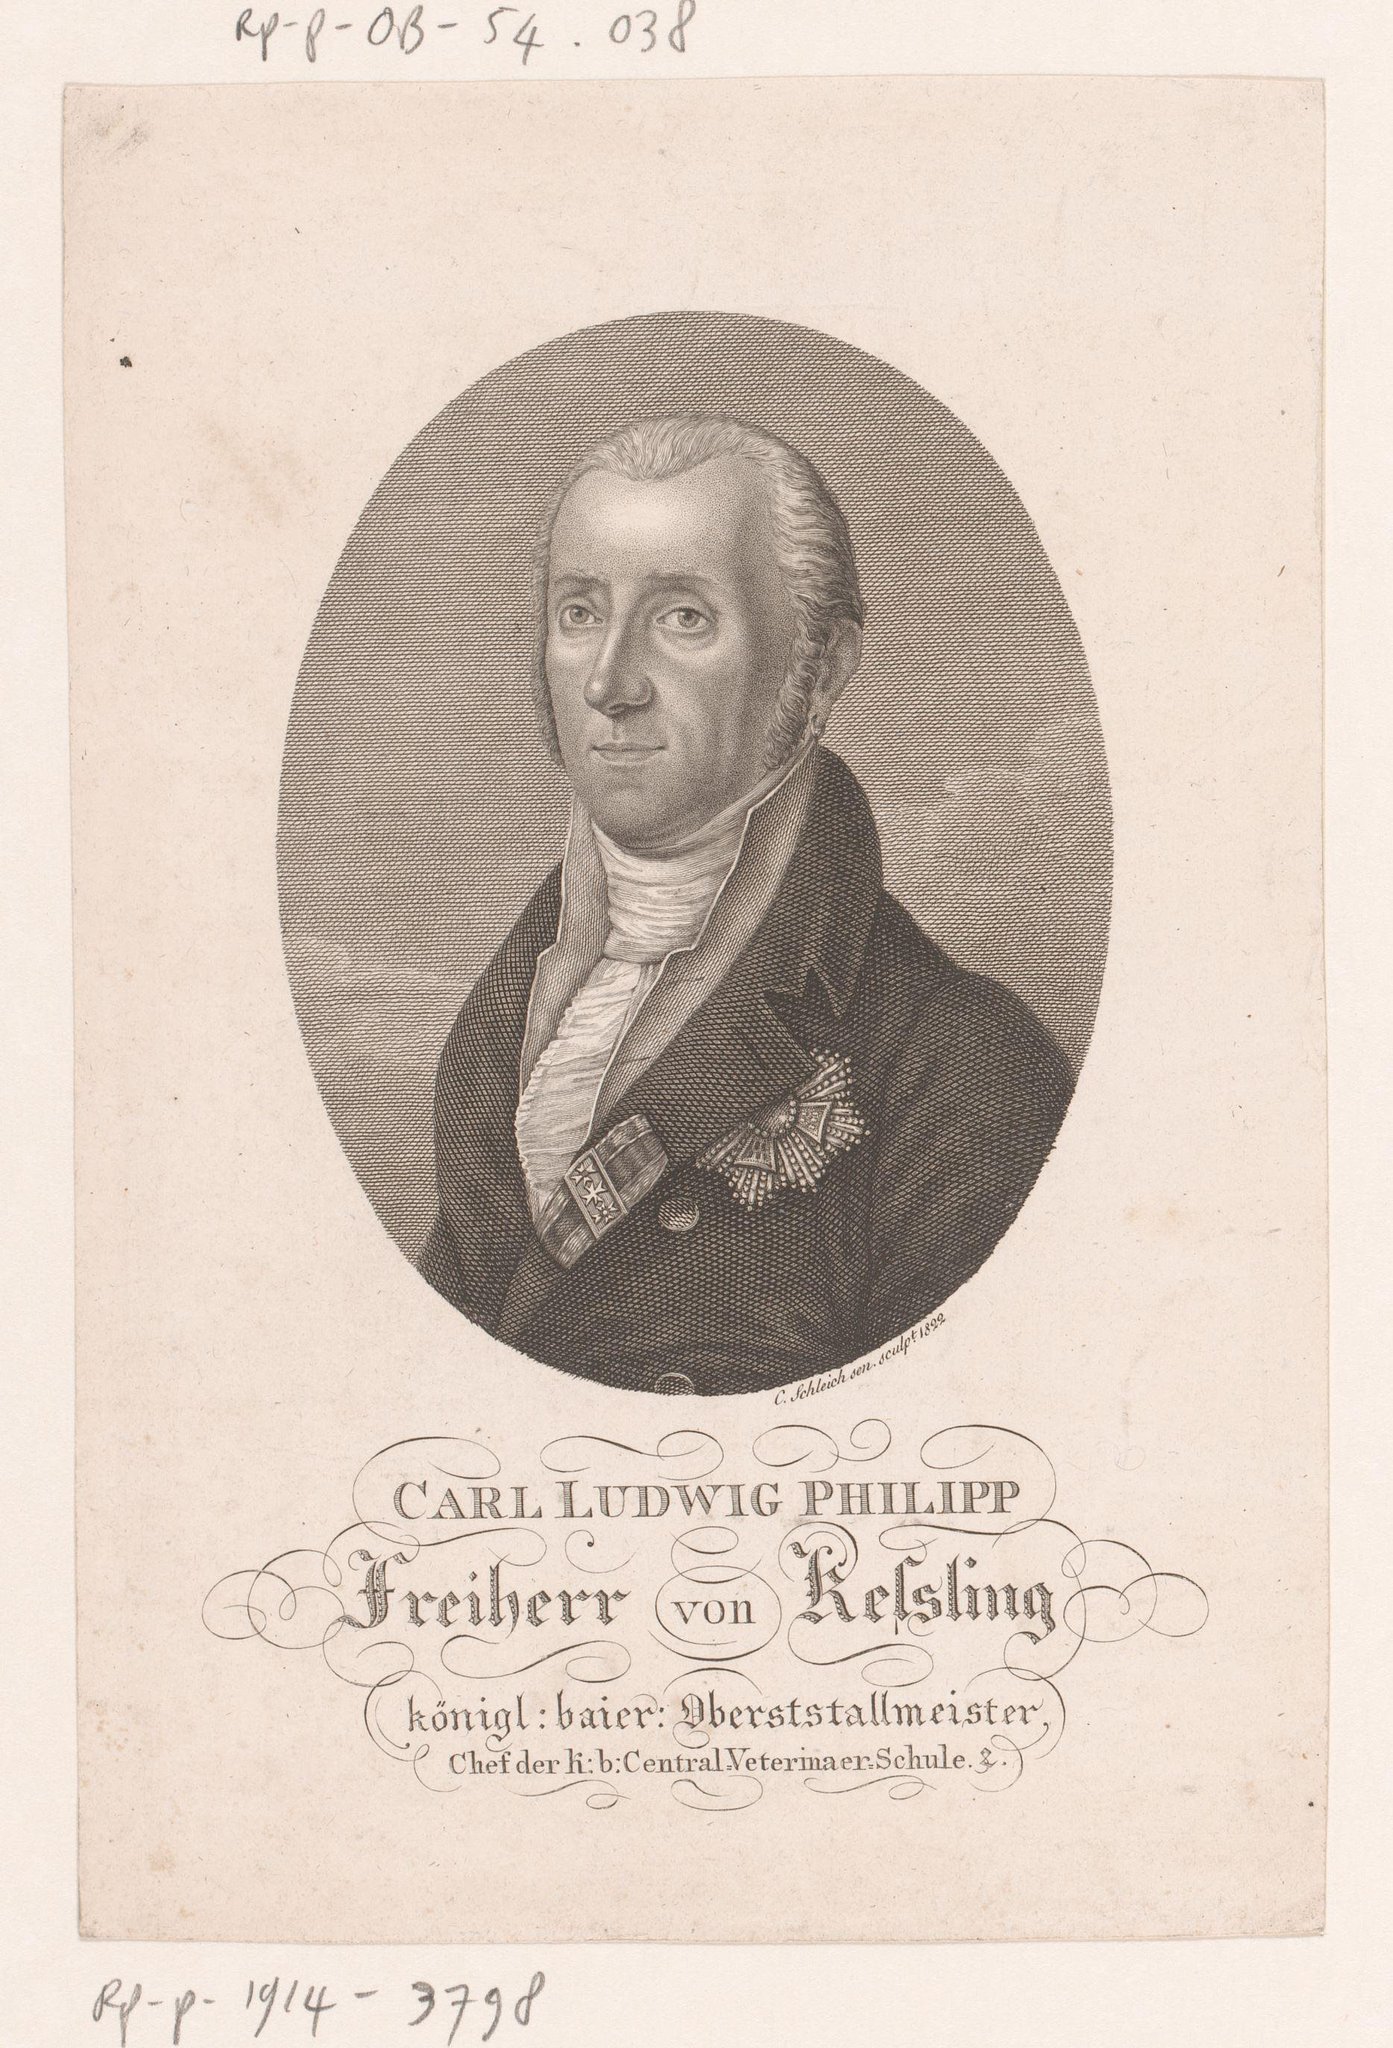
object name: print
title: Portret van Carl Ludwig von Kessling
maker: johann carl schleich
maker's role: print maker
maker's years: 1759-1842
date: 1822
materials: paper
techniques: engraving, etching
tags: politician, historical persons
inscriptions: collector's mark: Lugt 2228